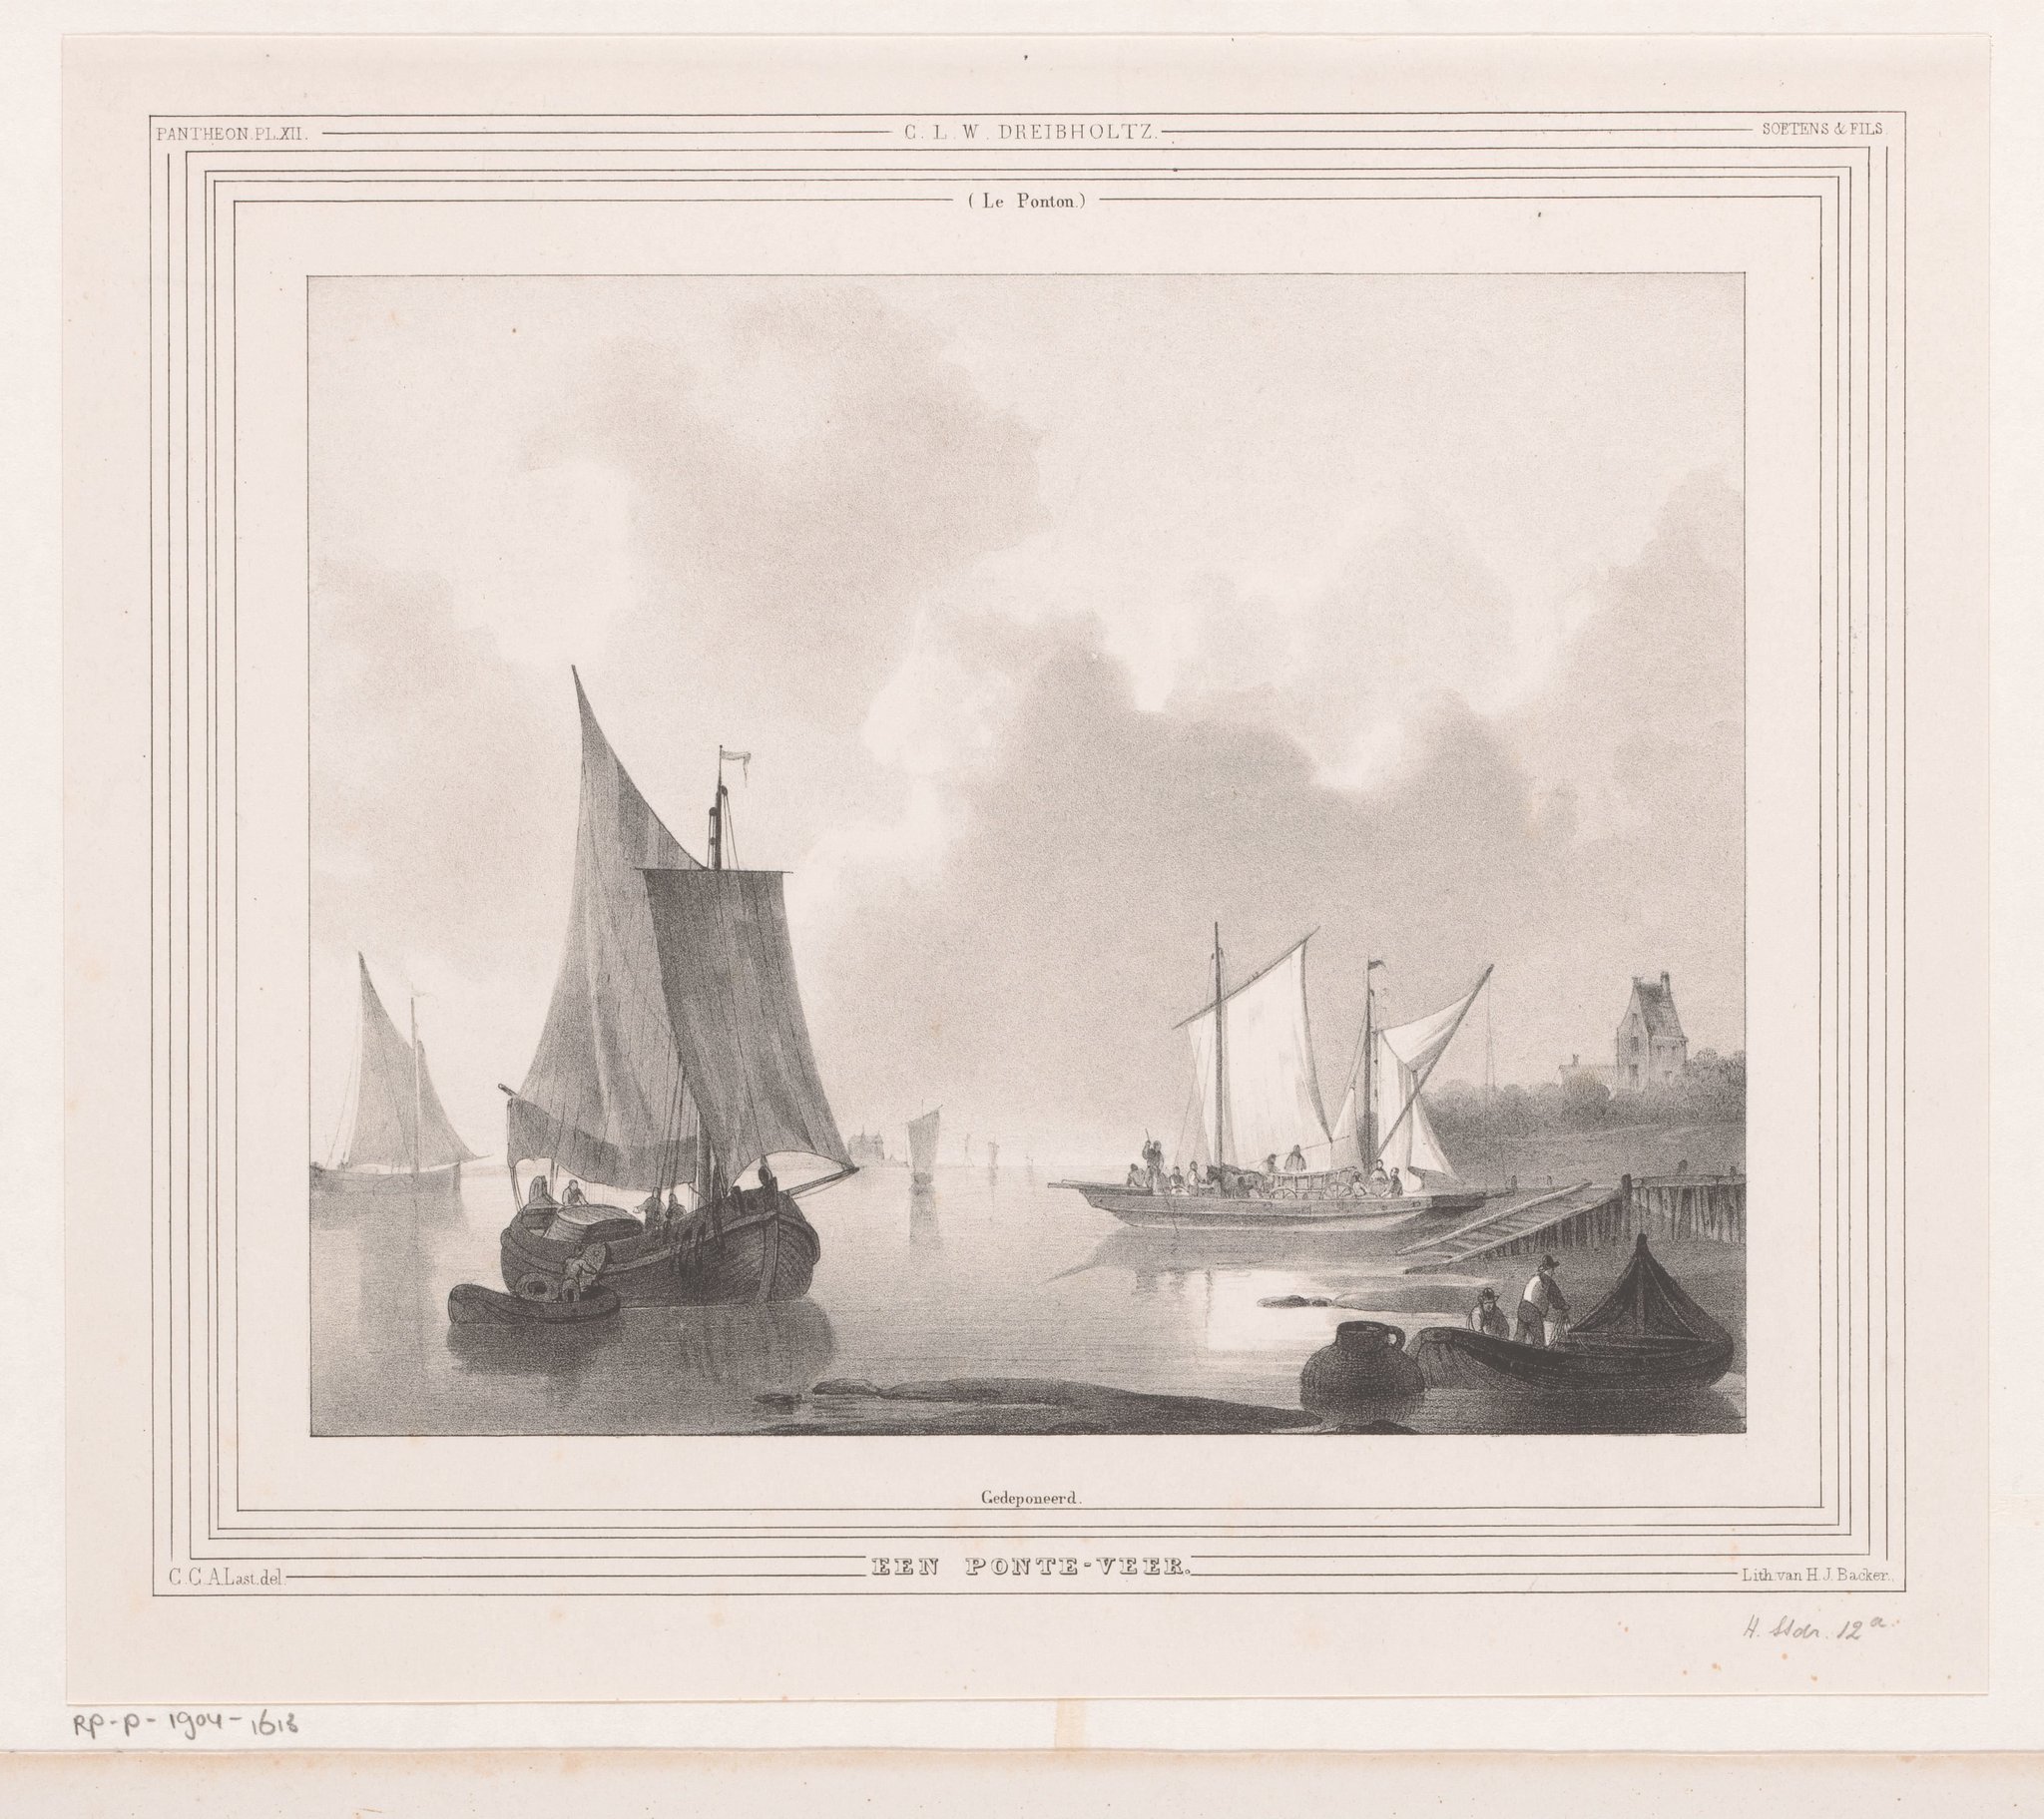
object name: print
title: Veerpont en andere schepen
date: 1837-1840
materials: paper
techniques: lithograph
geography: the hague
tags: sailing-ship, sailing-boat, ferry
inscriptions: collector's mark: Lugt 2228, : ‘Gedeponeerd.’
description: De veerpont is zojuist vertrokken. Op het dek figuren en een kar met twee paarden. Op het water verschillende zeilboten. Genummerd linksboven: Pantheon Pl. XII.